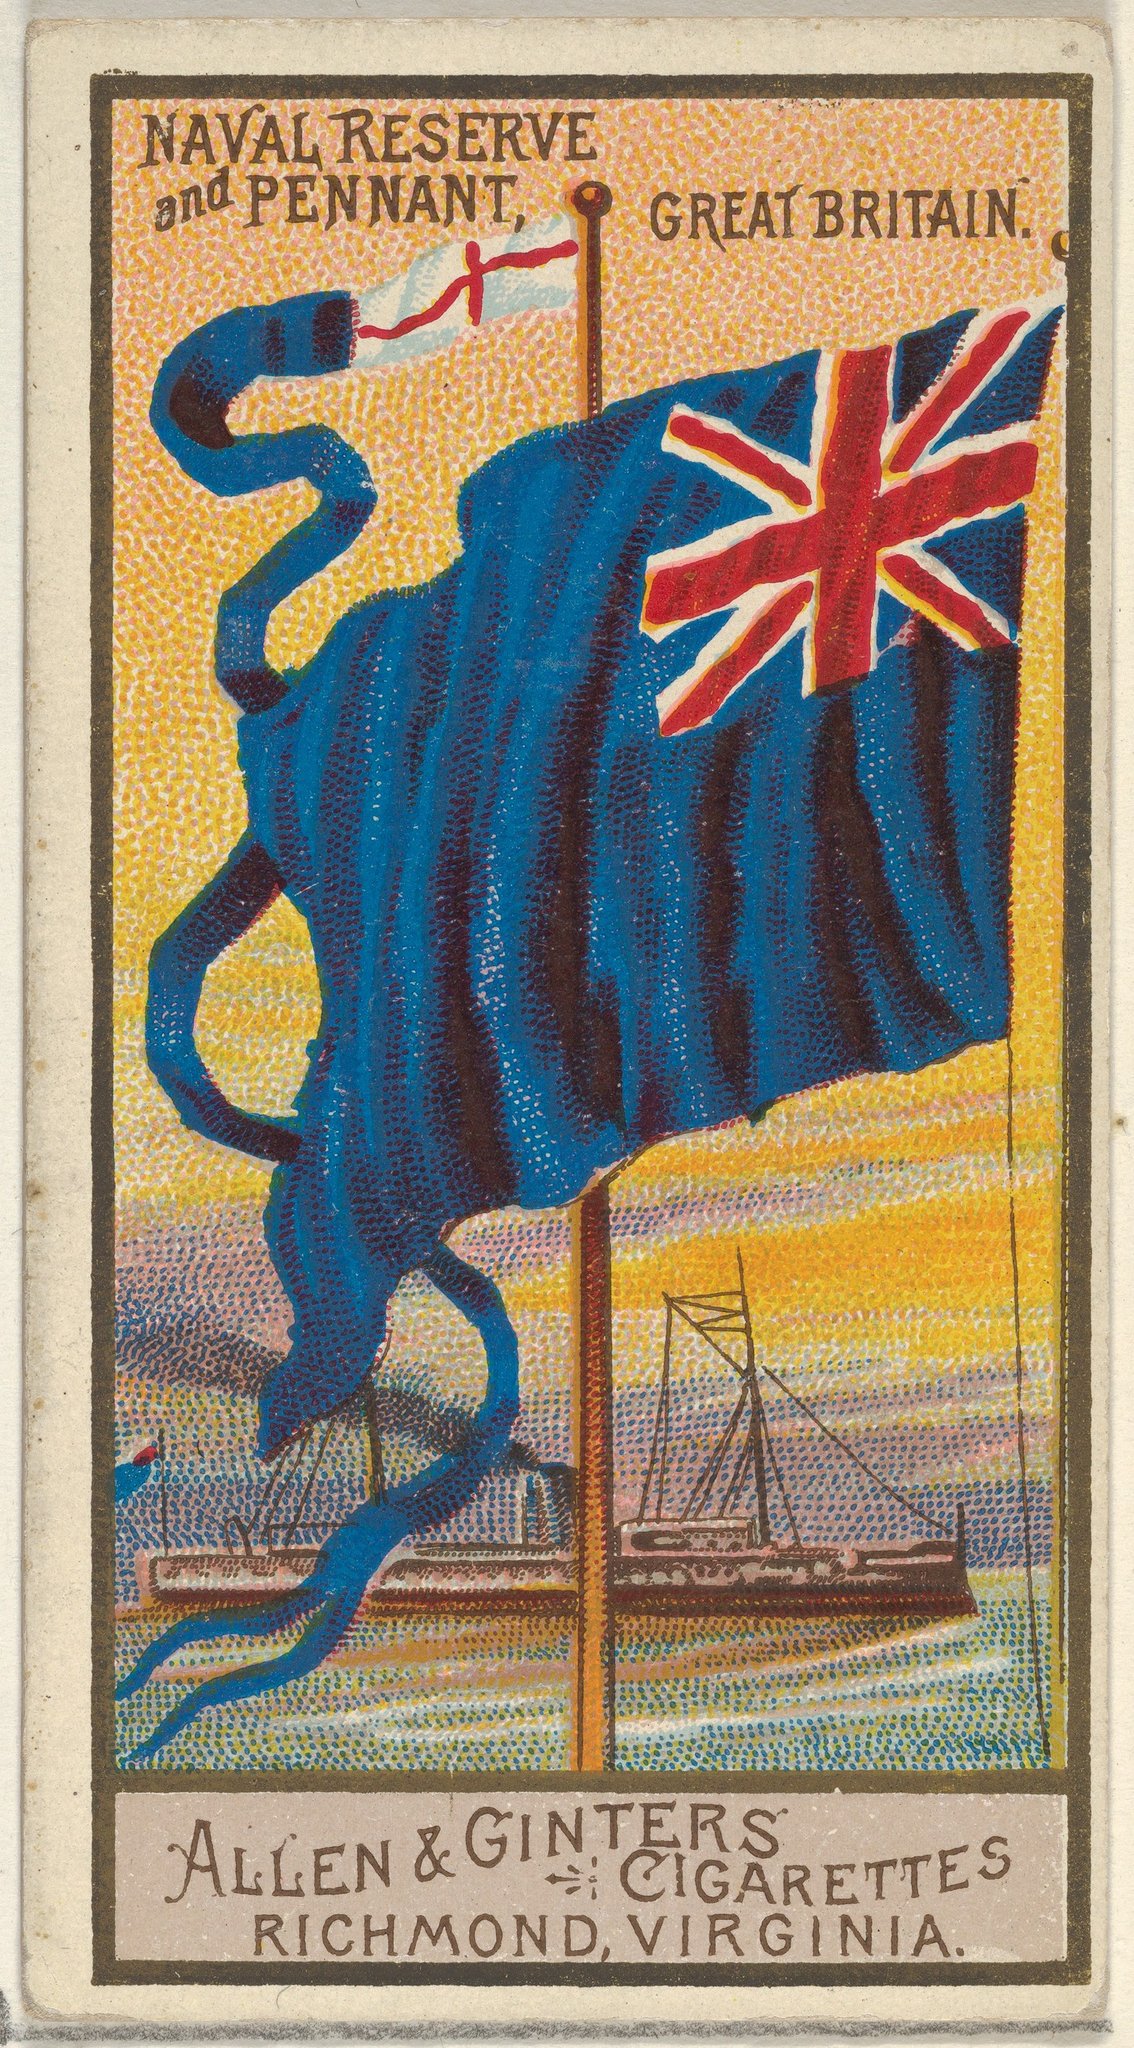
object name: print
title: Naval Reserve and Pennant, Great Britain, from the Naval Flags series (N17) for Allen & Ginter Cigarettes Brands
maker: allen & ginter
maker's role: publisher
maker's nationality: american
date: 1888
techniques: color lithograph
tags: flags